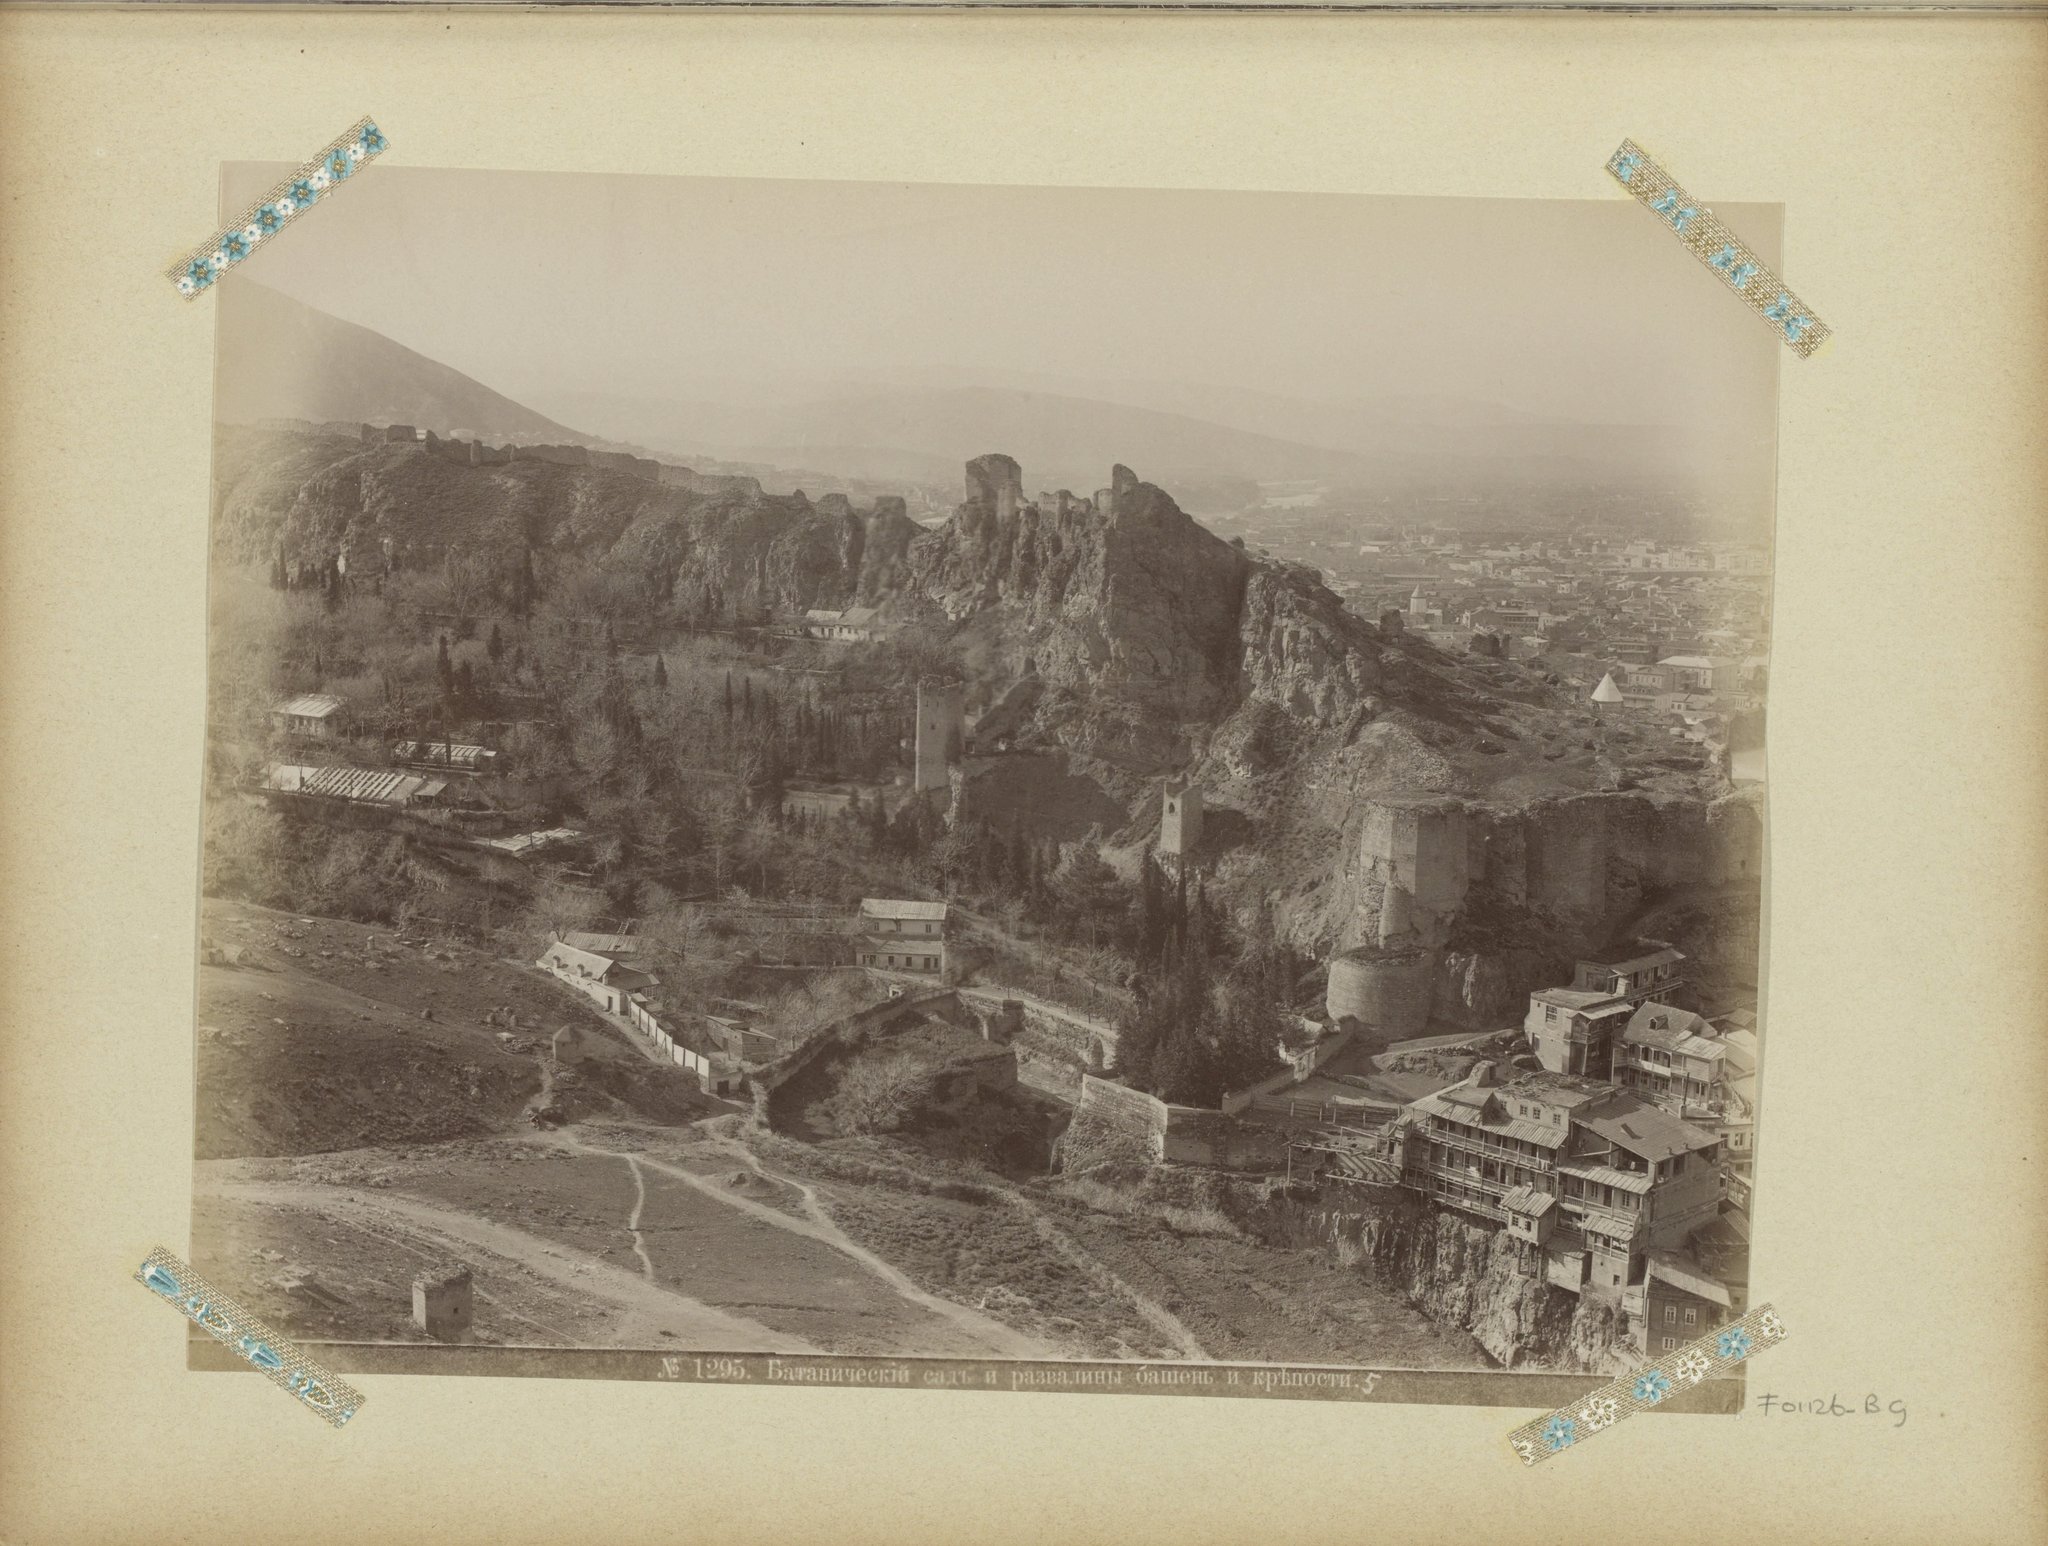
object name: photograph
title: Gezicht op tuin en kasteelruïne in Tiflis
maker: Anonymous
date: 1890-1900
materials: photographic support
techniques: albumen print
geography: tbilisi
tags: garden, prospect of city, town panorama, silhouette of city, ruin of a dwelling, house, castle, etc.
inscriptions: number: ‘1295’, number: ‘5’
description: Onderdeel van Fotoalbum met opnames van bezienswaardigheden in Georgië, Sint-Petersburg en Moskou.